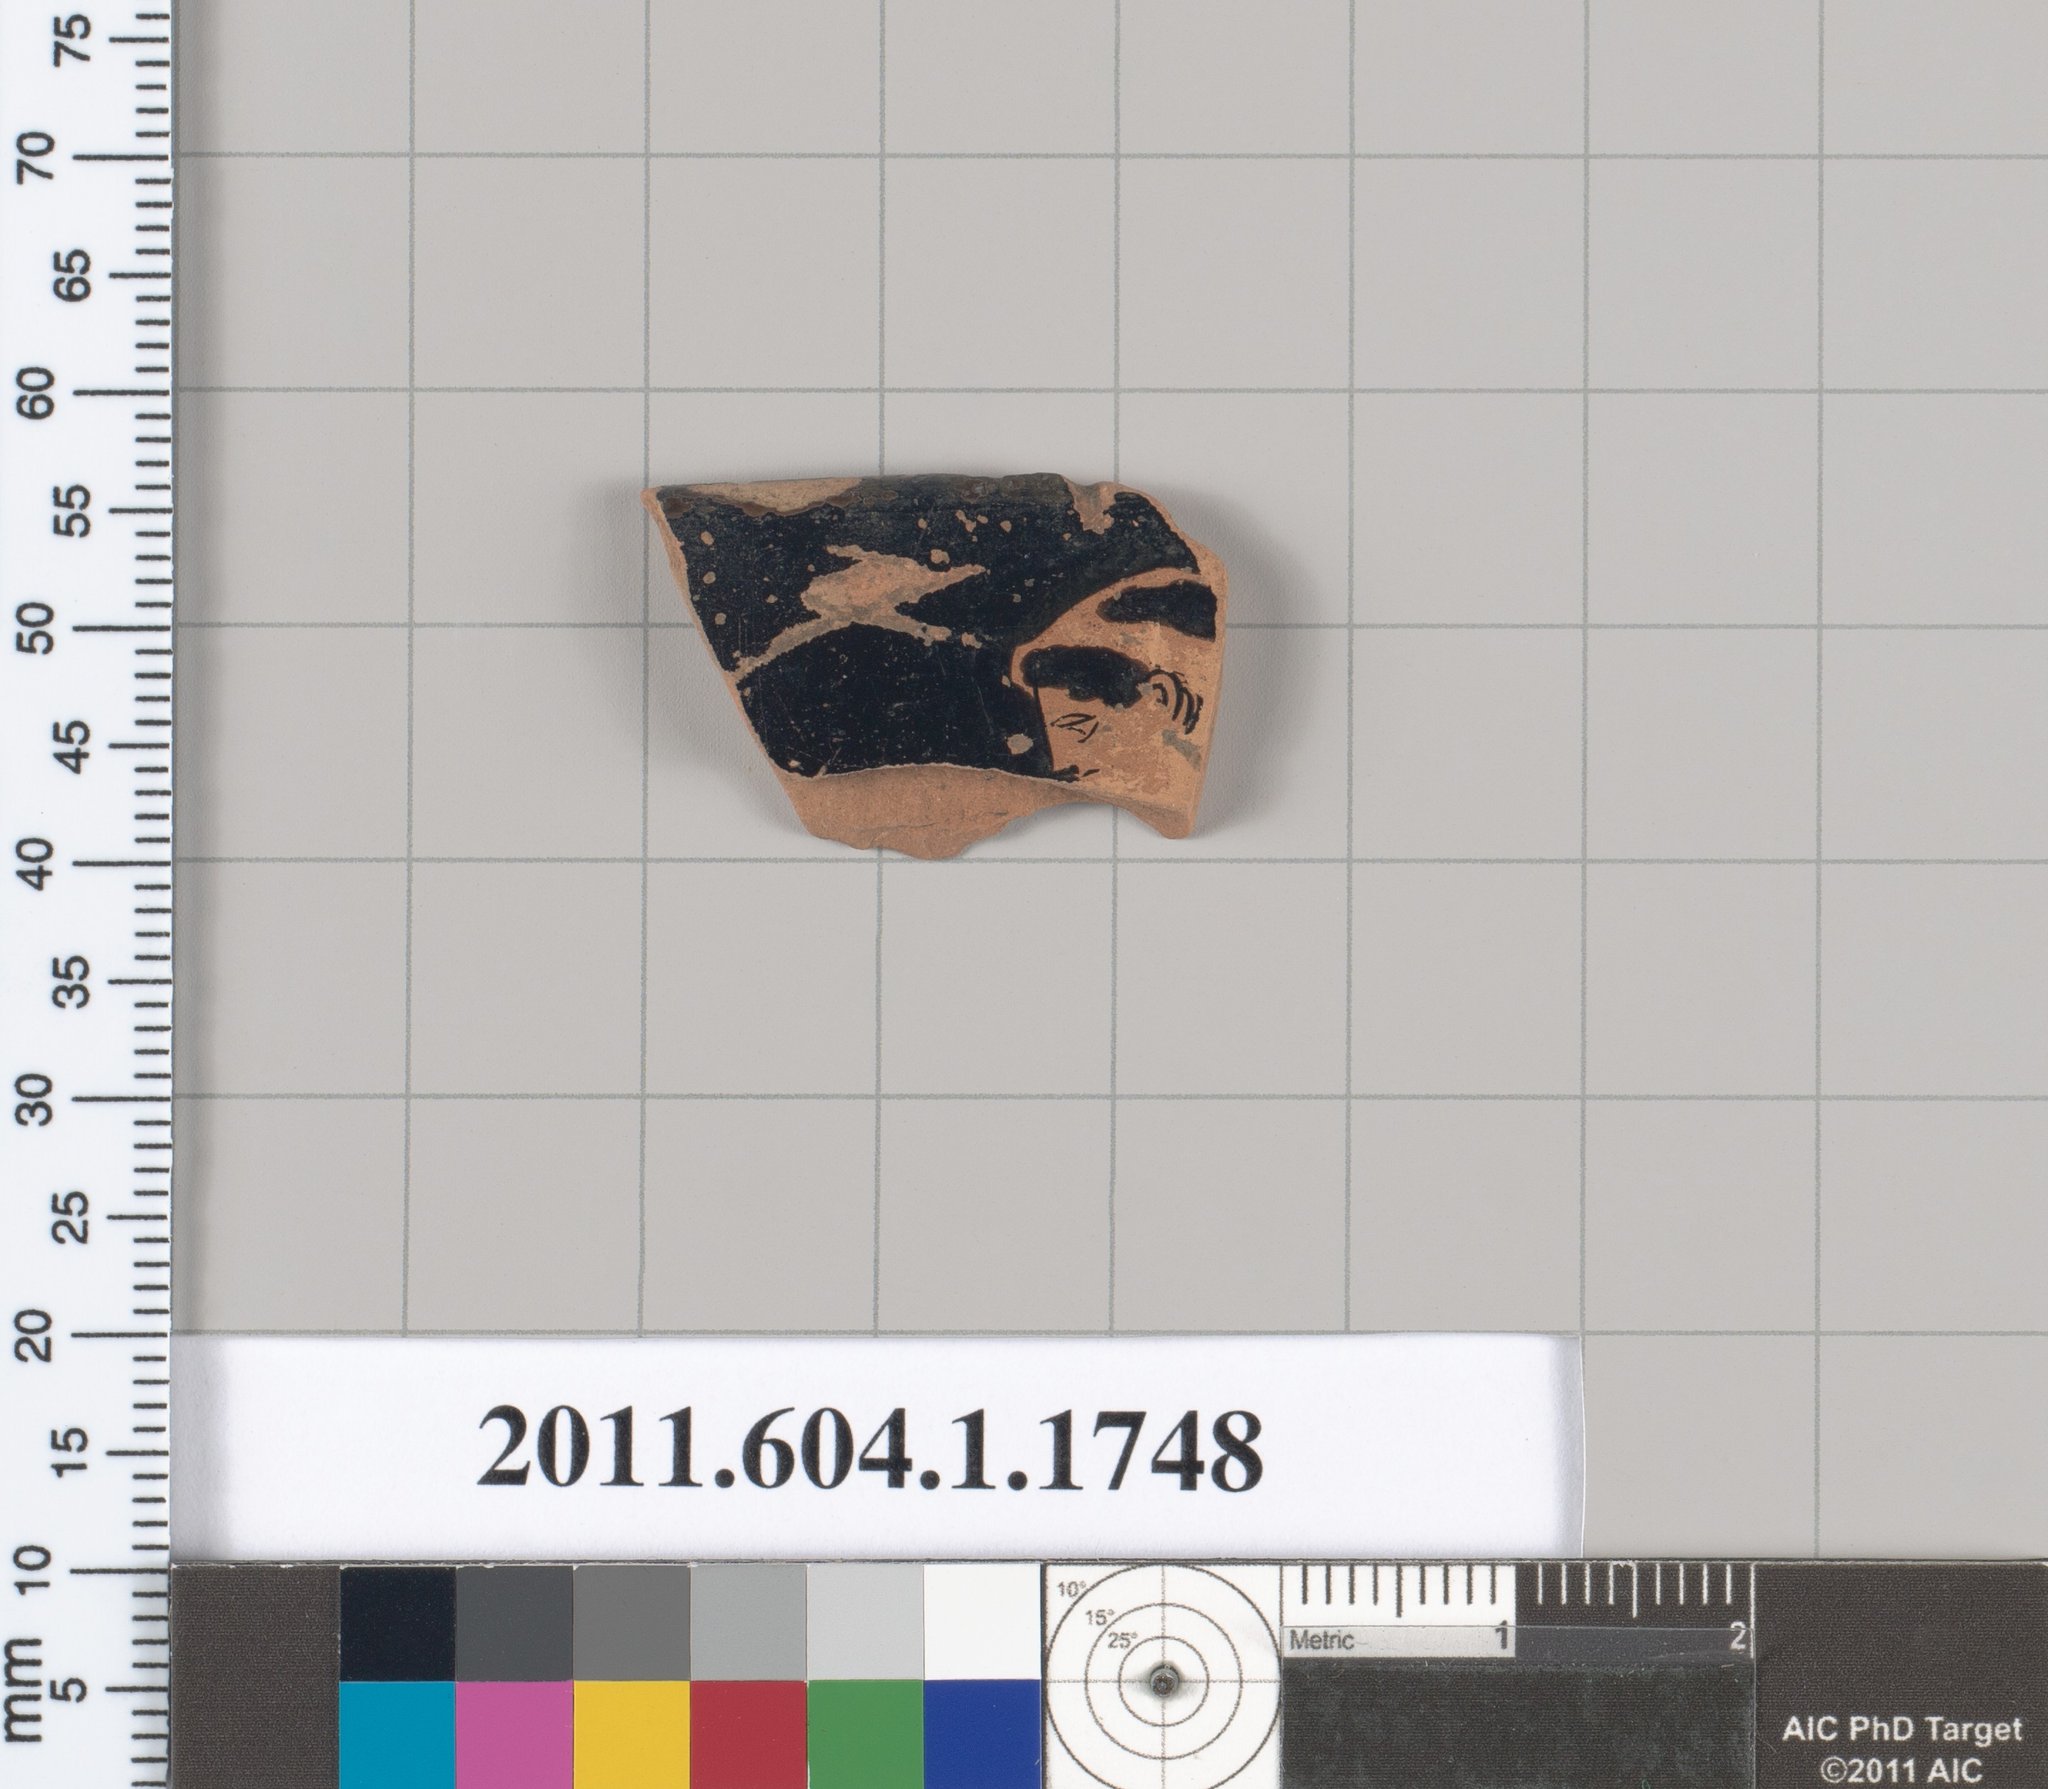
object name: kylix fragment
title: Terracotta rim fragment of a kylix (drinking cup)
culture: greek, attic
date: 467-435 BCE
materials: terracotta